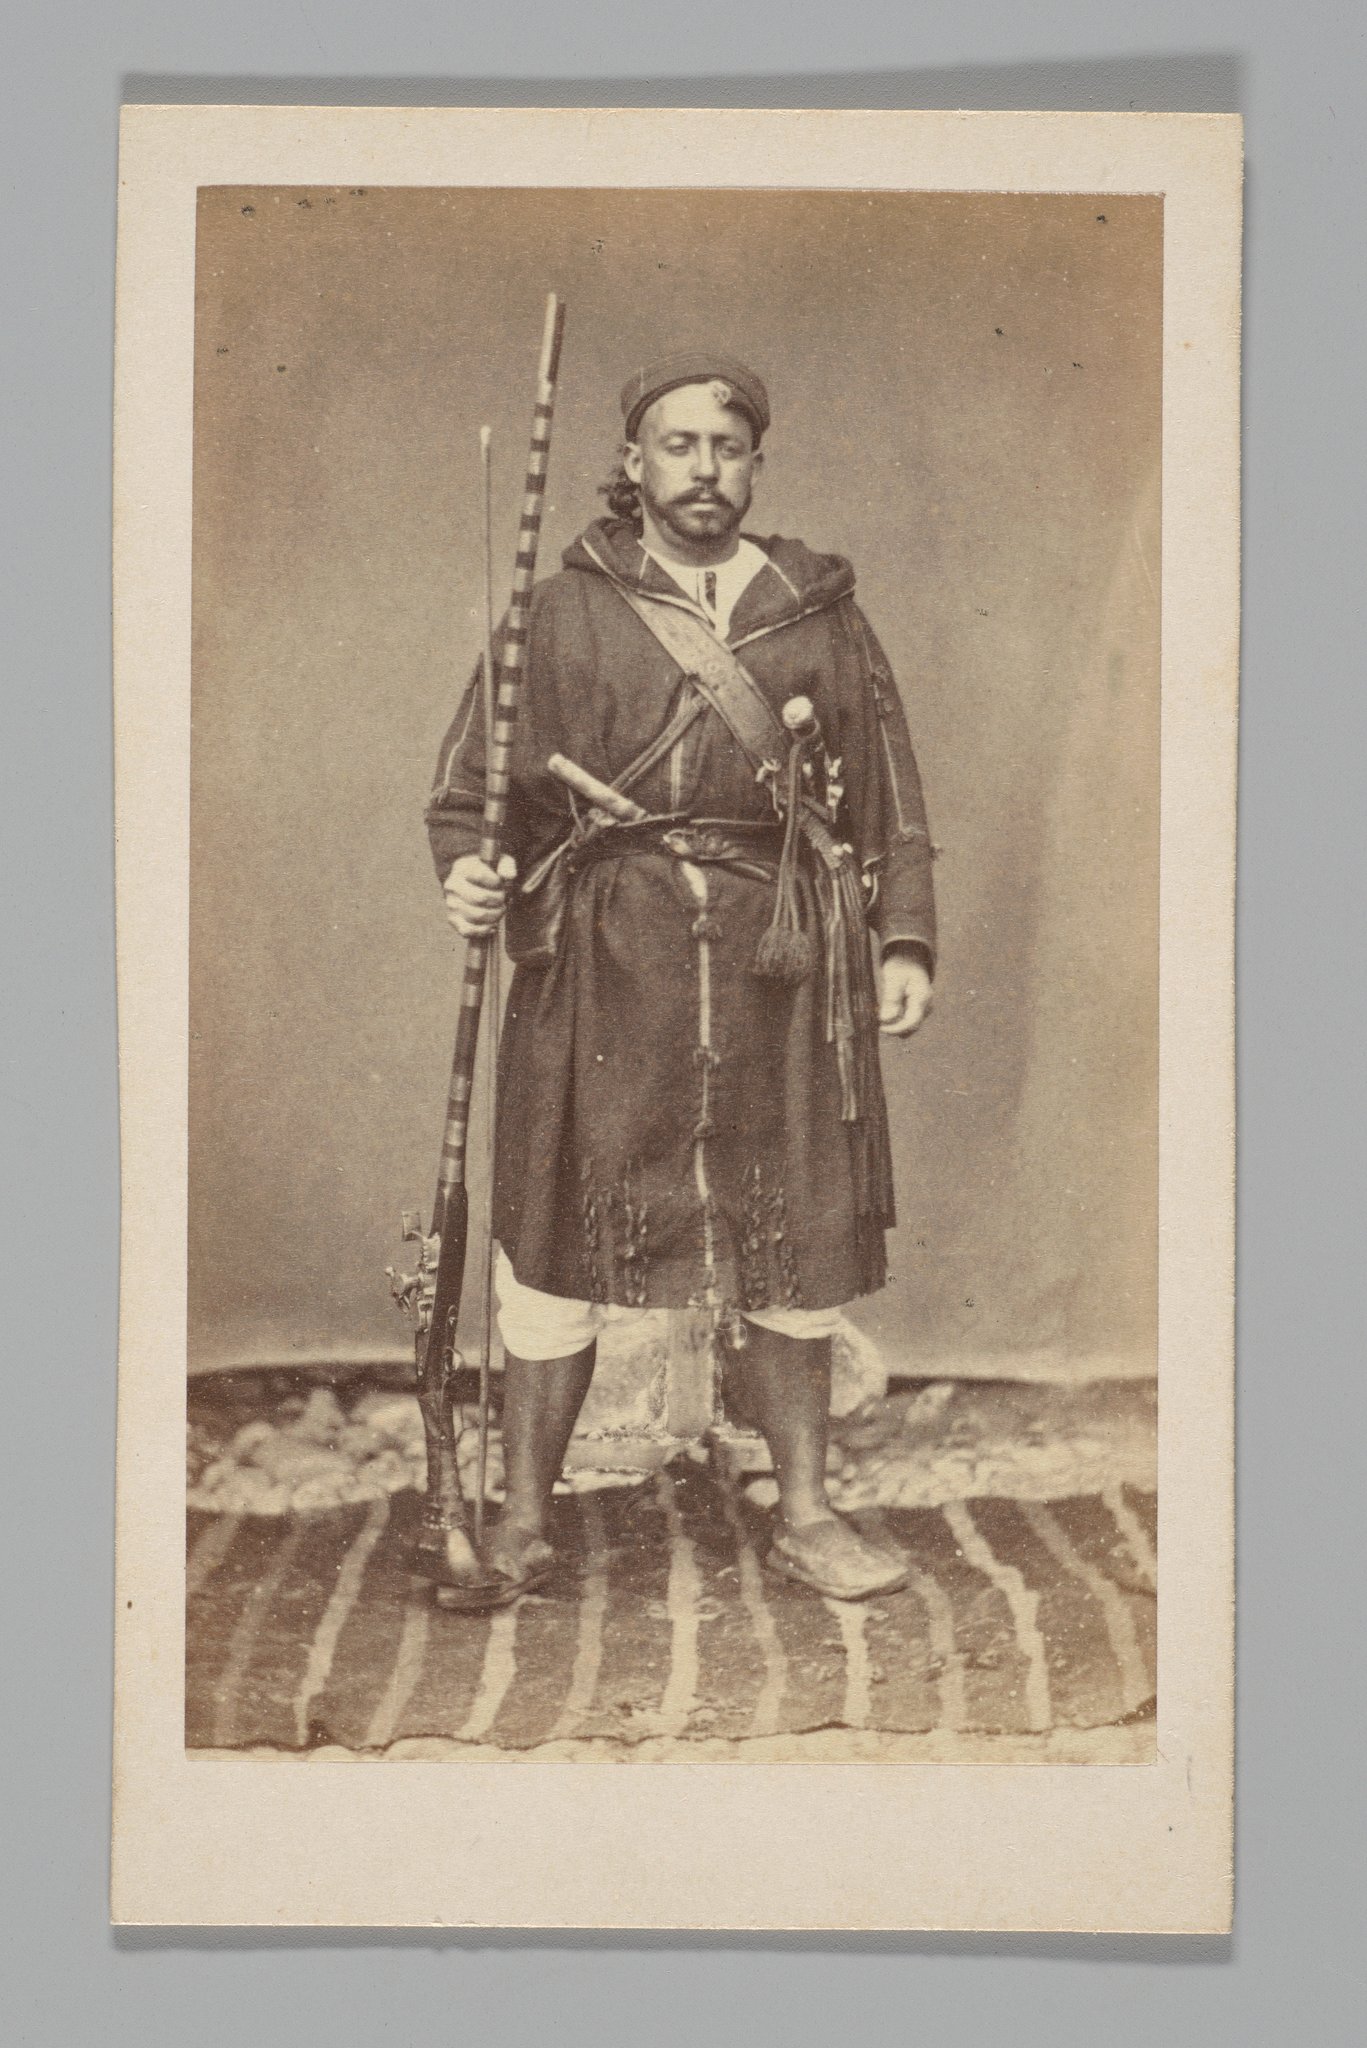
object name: carte de visite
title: [Man, Morocco]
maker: a. chauffy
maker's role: artist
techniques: albumen silver print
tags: firearms,men,portraits